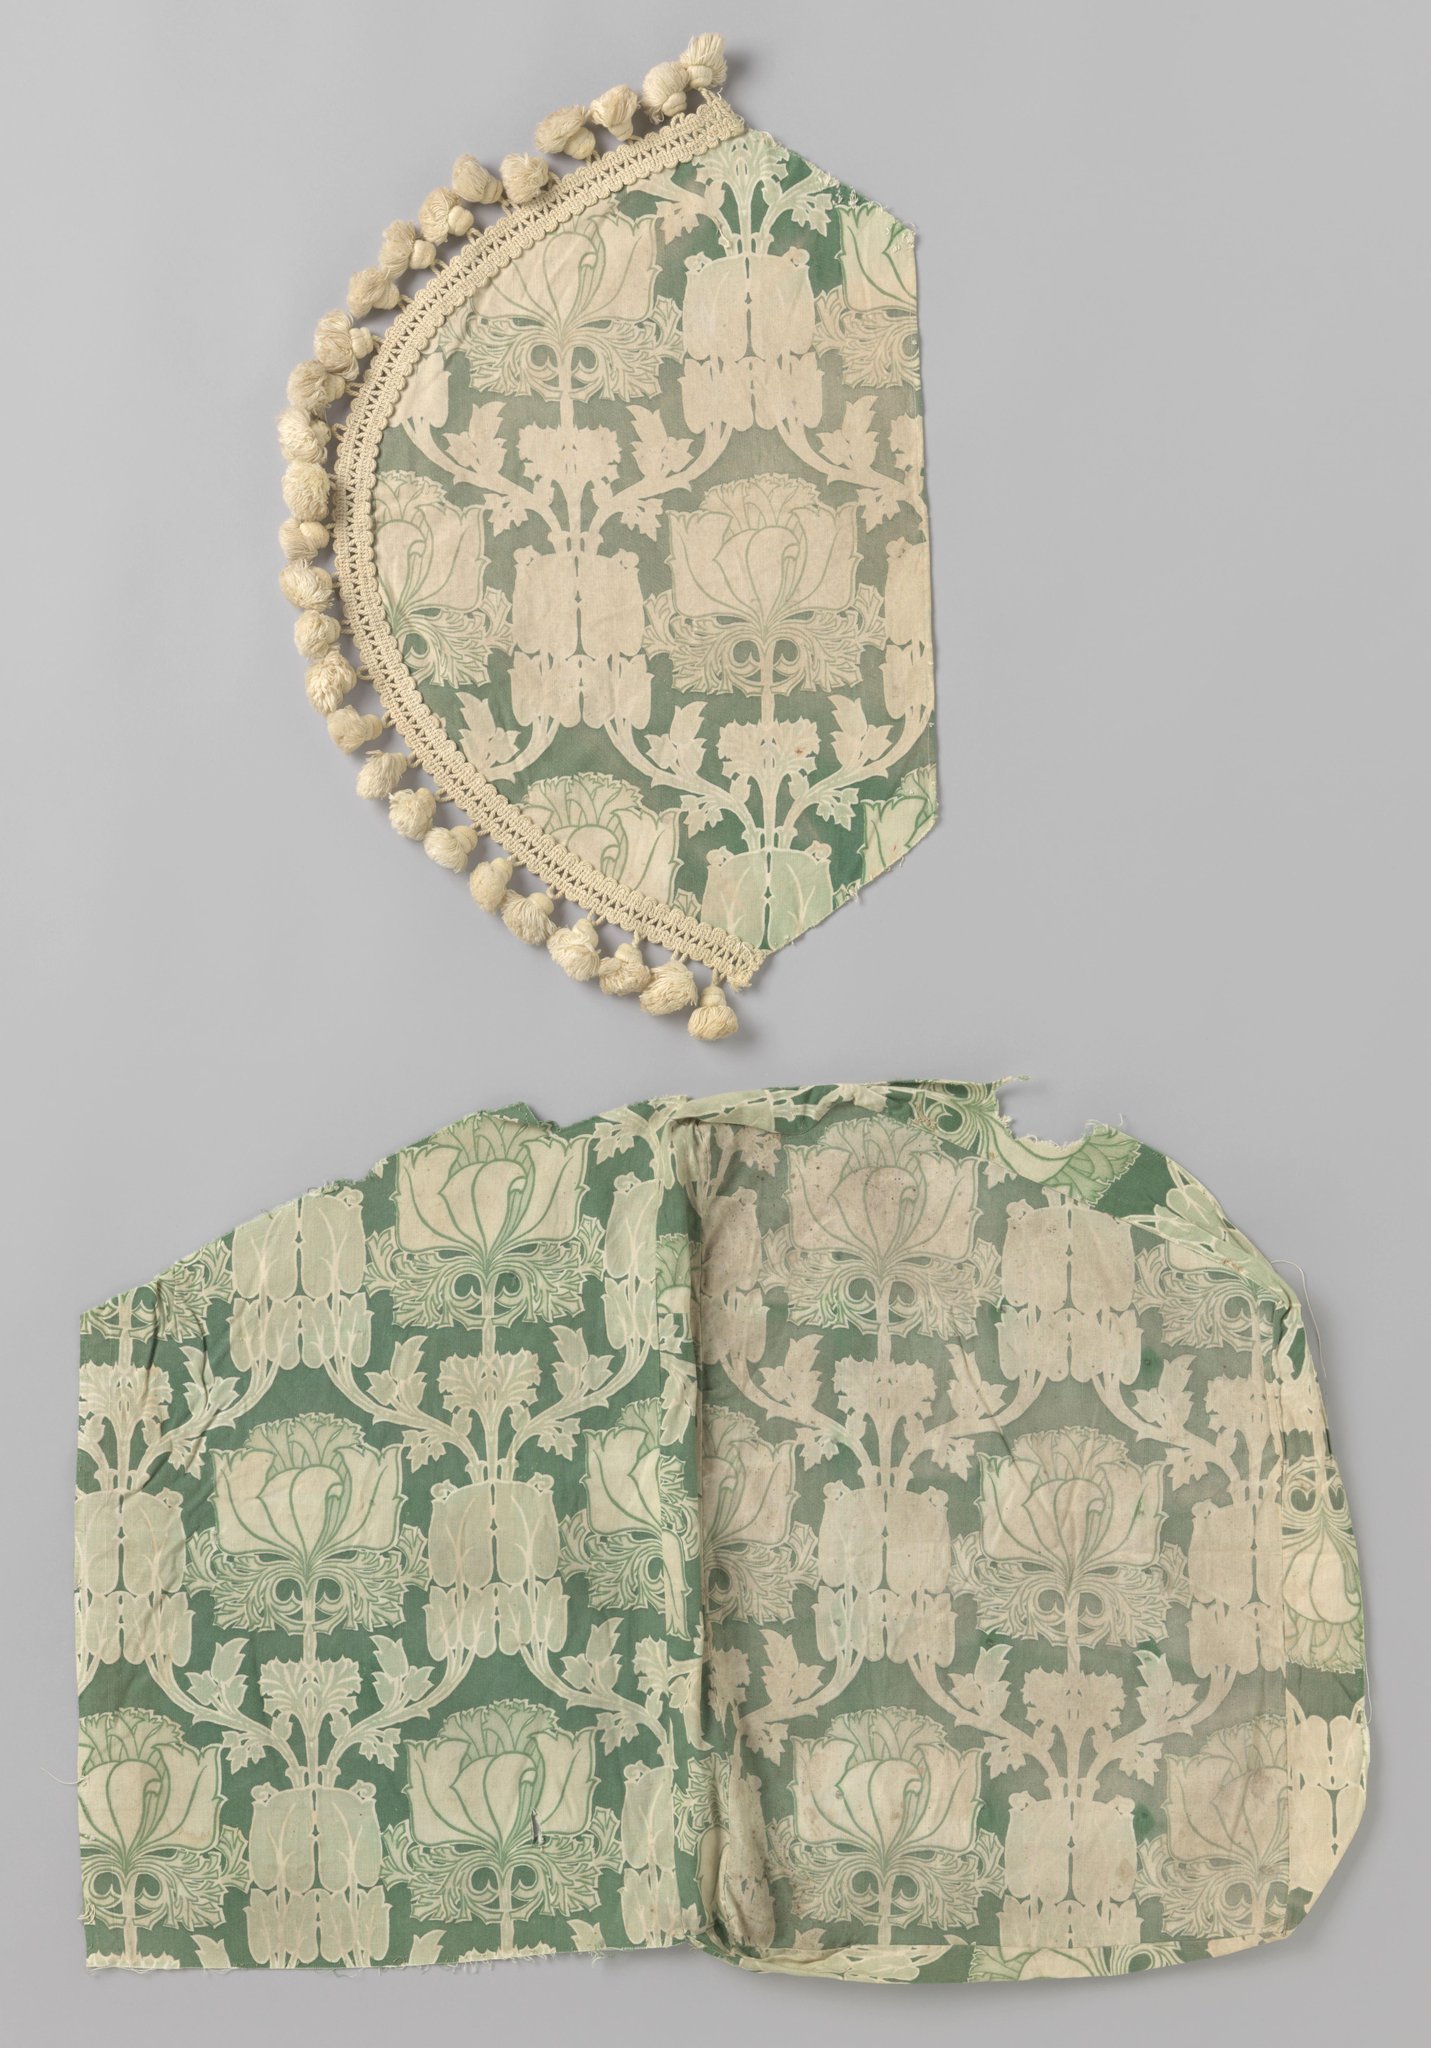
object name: interieuronderdeel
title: Drie kussenovertrekken voor tuinbank van groen-wit bedrukte zware katoen met patroon van iris- of leliebloemen in spitsovale opgroeiende stengels in de stijl van William Morris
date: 1890-1900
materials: cotton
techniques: printing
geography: england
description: Drie kussenovertrekken voor tuinbank van groen-wit bedrukte zware katoen met patroon van iris- of leliebloemen in spitsovale opgroeiende stengels in de stijl van William Morris. Patroon: grote symmetrische irissen of lelies met groen omlijnde witte en lichtgroene bloembladeren op flesgroene grond. Zij staan in verspringende rijen binnen spitsovaal opgaande dubbele wit omlijnde stengels met tweemaal een drieblad op de knooppunten.